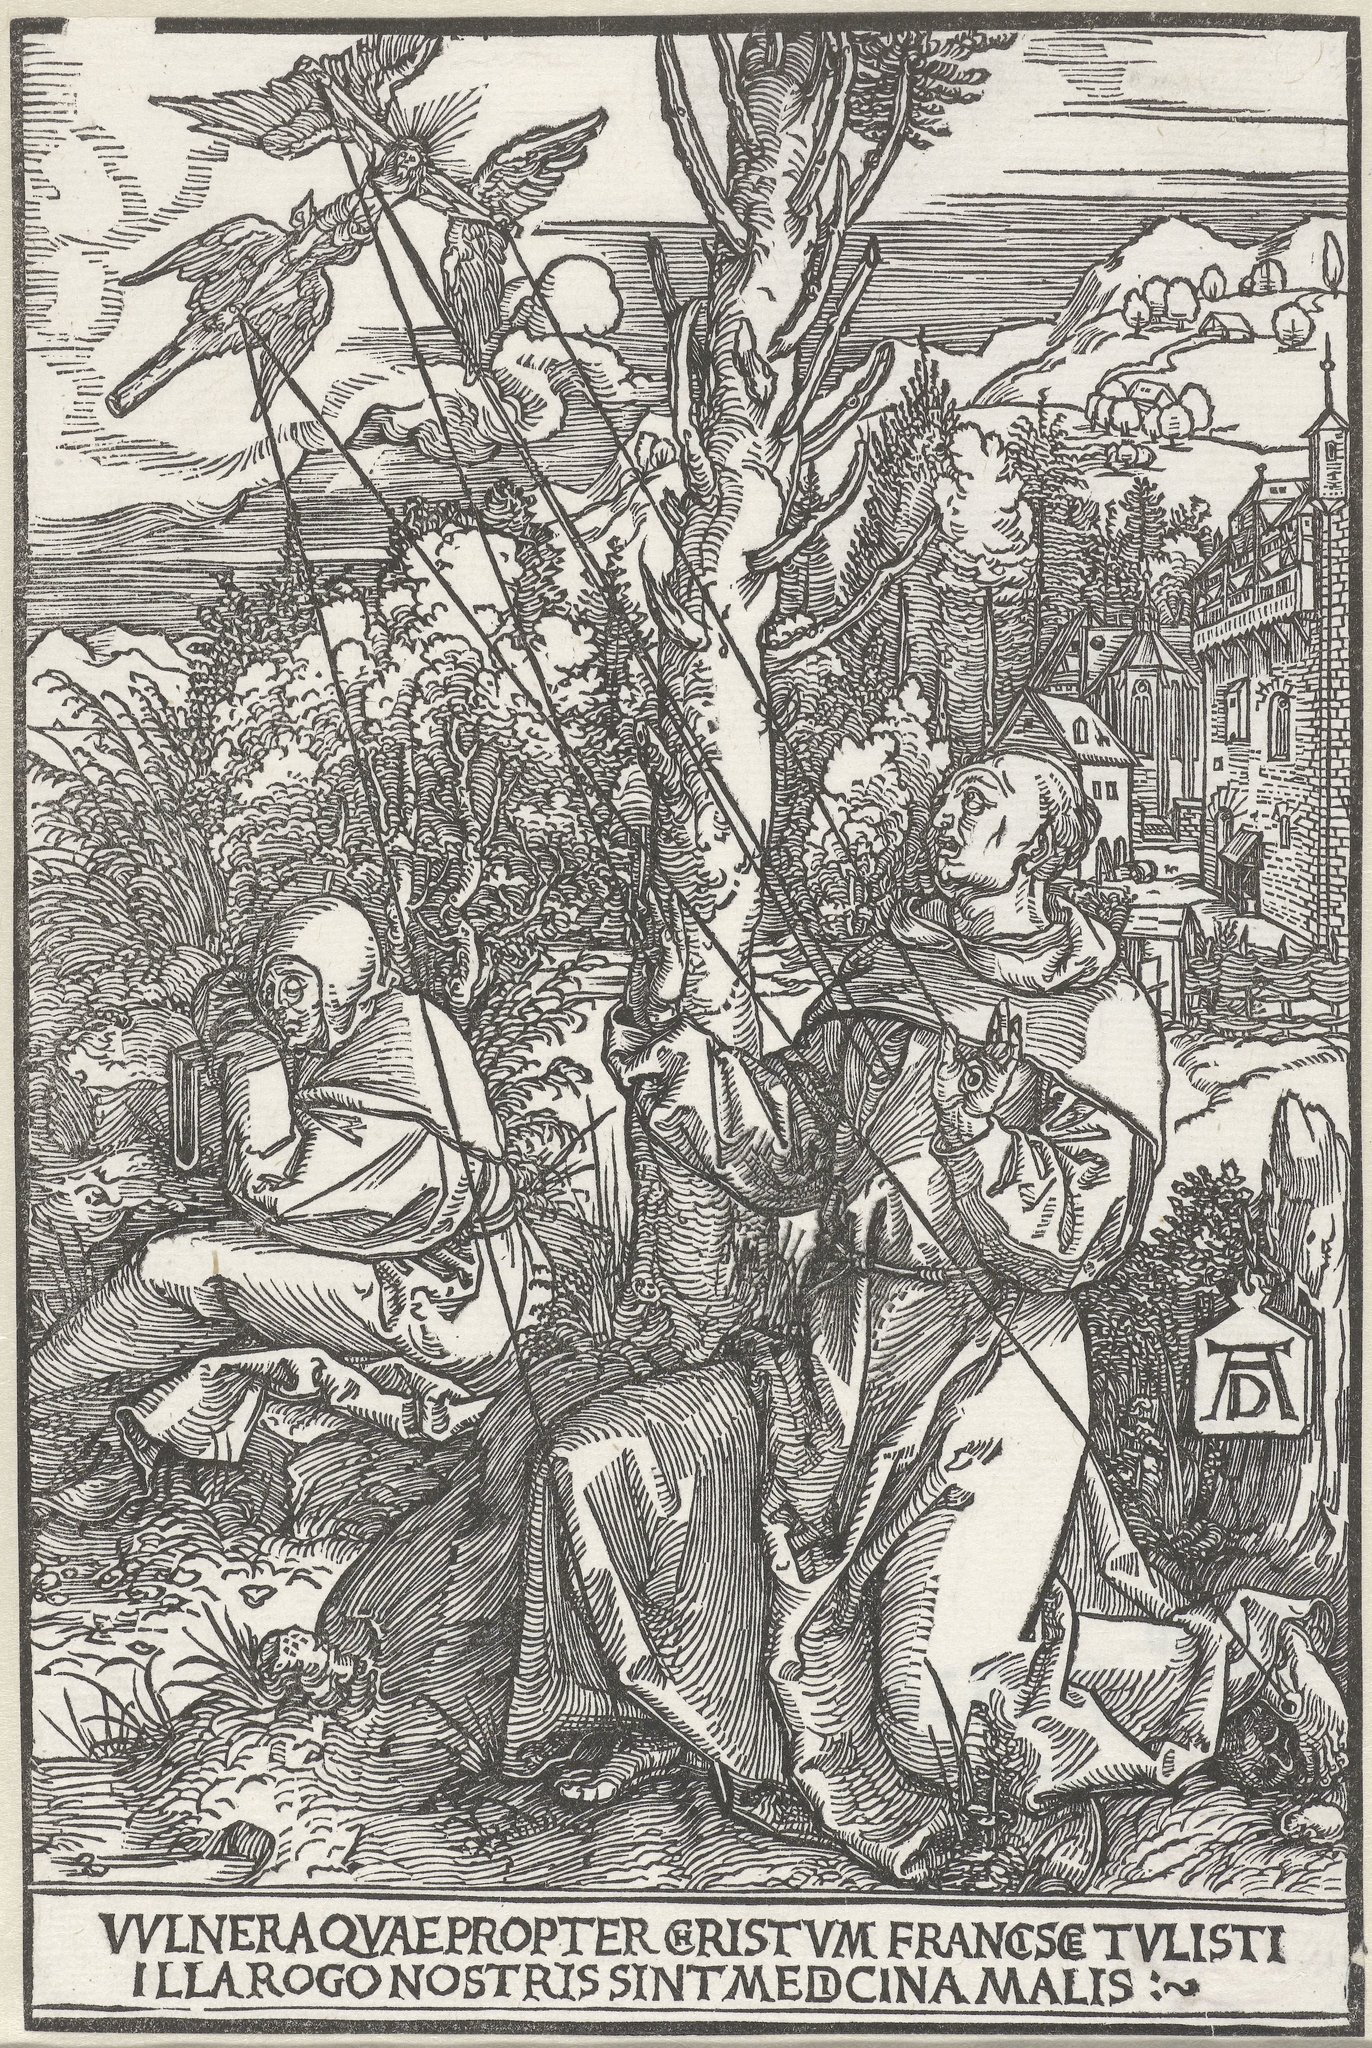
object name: print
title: De stigmatisatie van de Heilige Franciscus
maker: albrecht dürer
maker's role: draughtsman, painter, print maker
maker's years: 1471-1528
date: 1503-1504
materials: paper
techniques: woodcut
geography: nuremberg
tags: stigmatization of st. francis of assisi: in retreat on mount alverna, he beholds a vision of christ on the cross enveloped by wings (like a seraph with six wings); rays passing down to the body of the kneeling saint form the marks of the five wounds of christ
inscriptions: collector's mark: Lugt 240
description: De Heilige Franciscus ontvangt geknield de stigmata van een crucifix, die aan drie paar vleugels in de lucht zweeft. Links zit een man te slapen. Op de achtergrond een stadje. Onder de voorstelling twee regels Latijnse tekst.